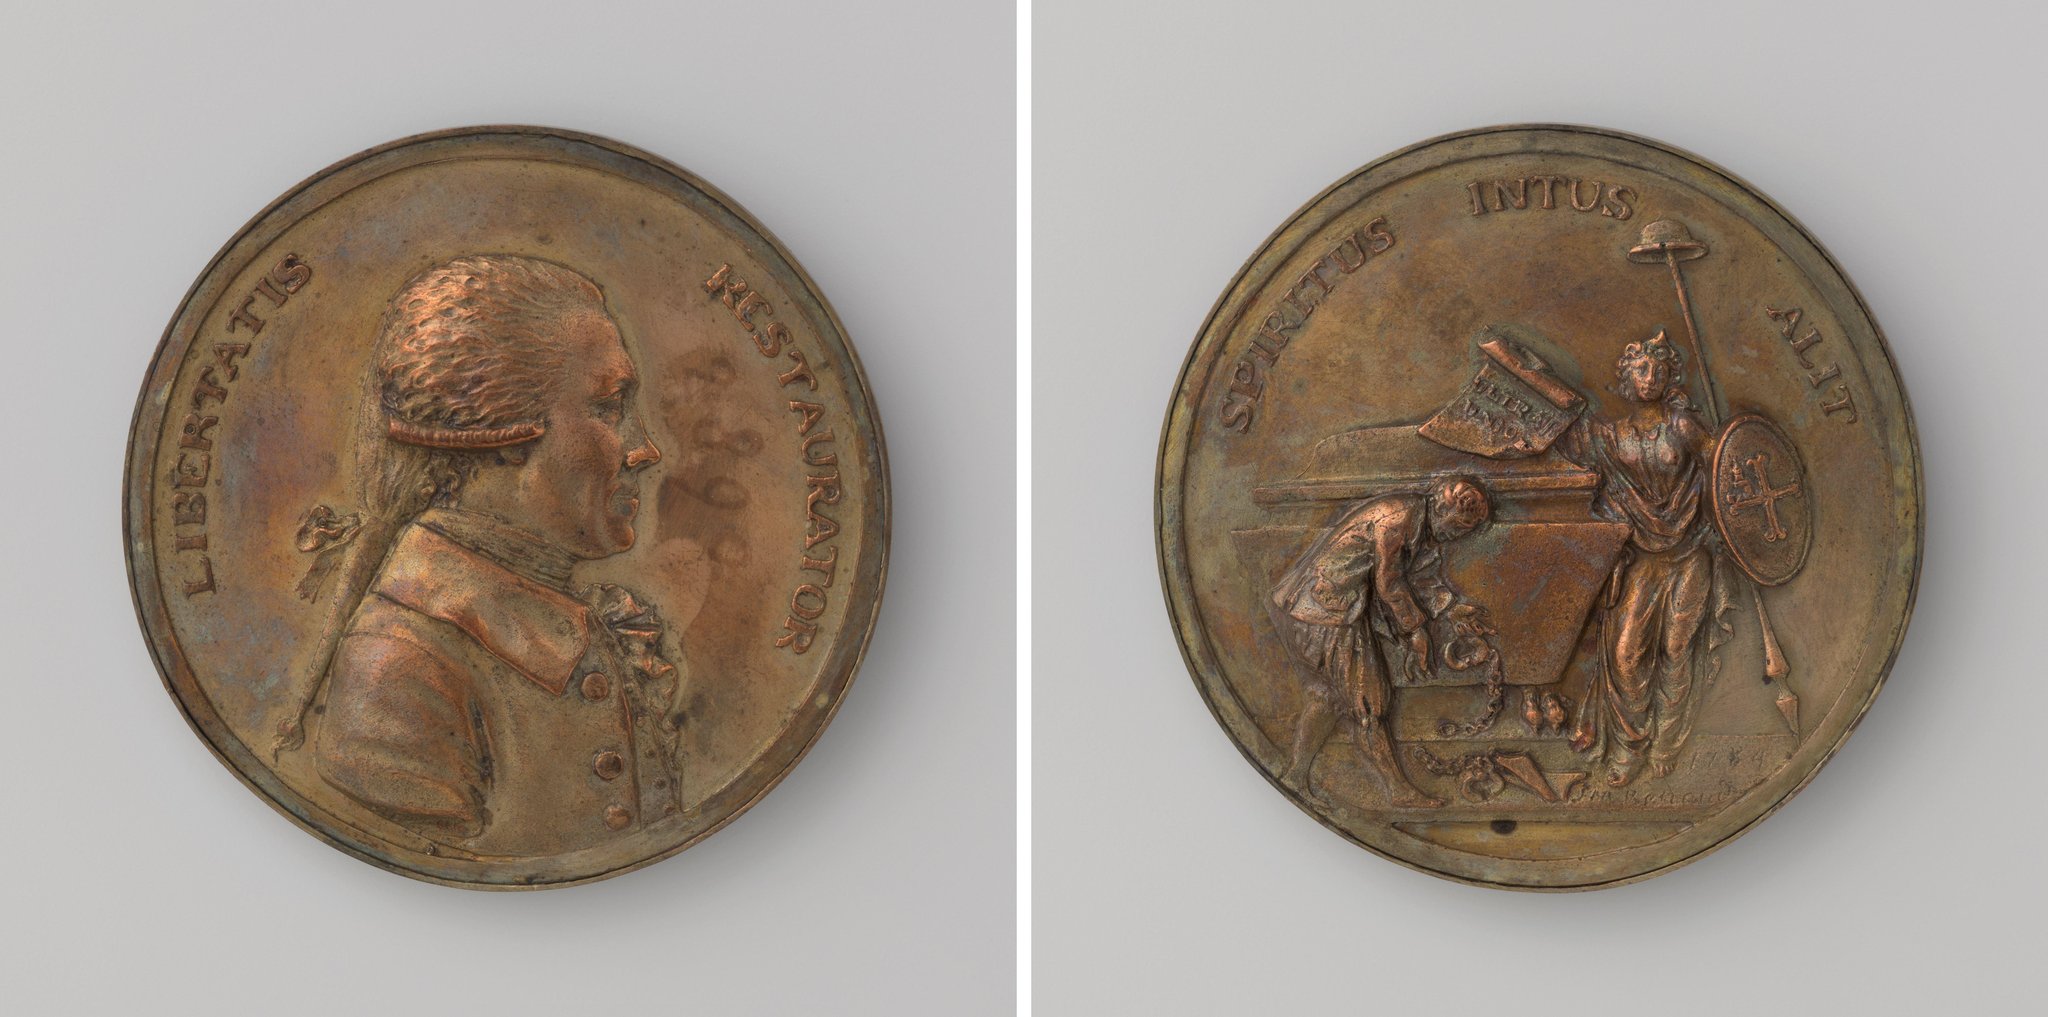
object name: history medal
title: Overlijden van Joan Derk van der Capellen tot den Pol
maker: jean martin renaud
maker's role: medailleur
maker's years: 1746-1821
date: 1784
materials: bronze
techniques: engraving, galvanization, striking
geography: paris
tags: politician, joan derk van der capellen tot den pol